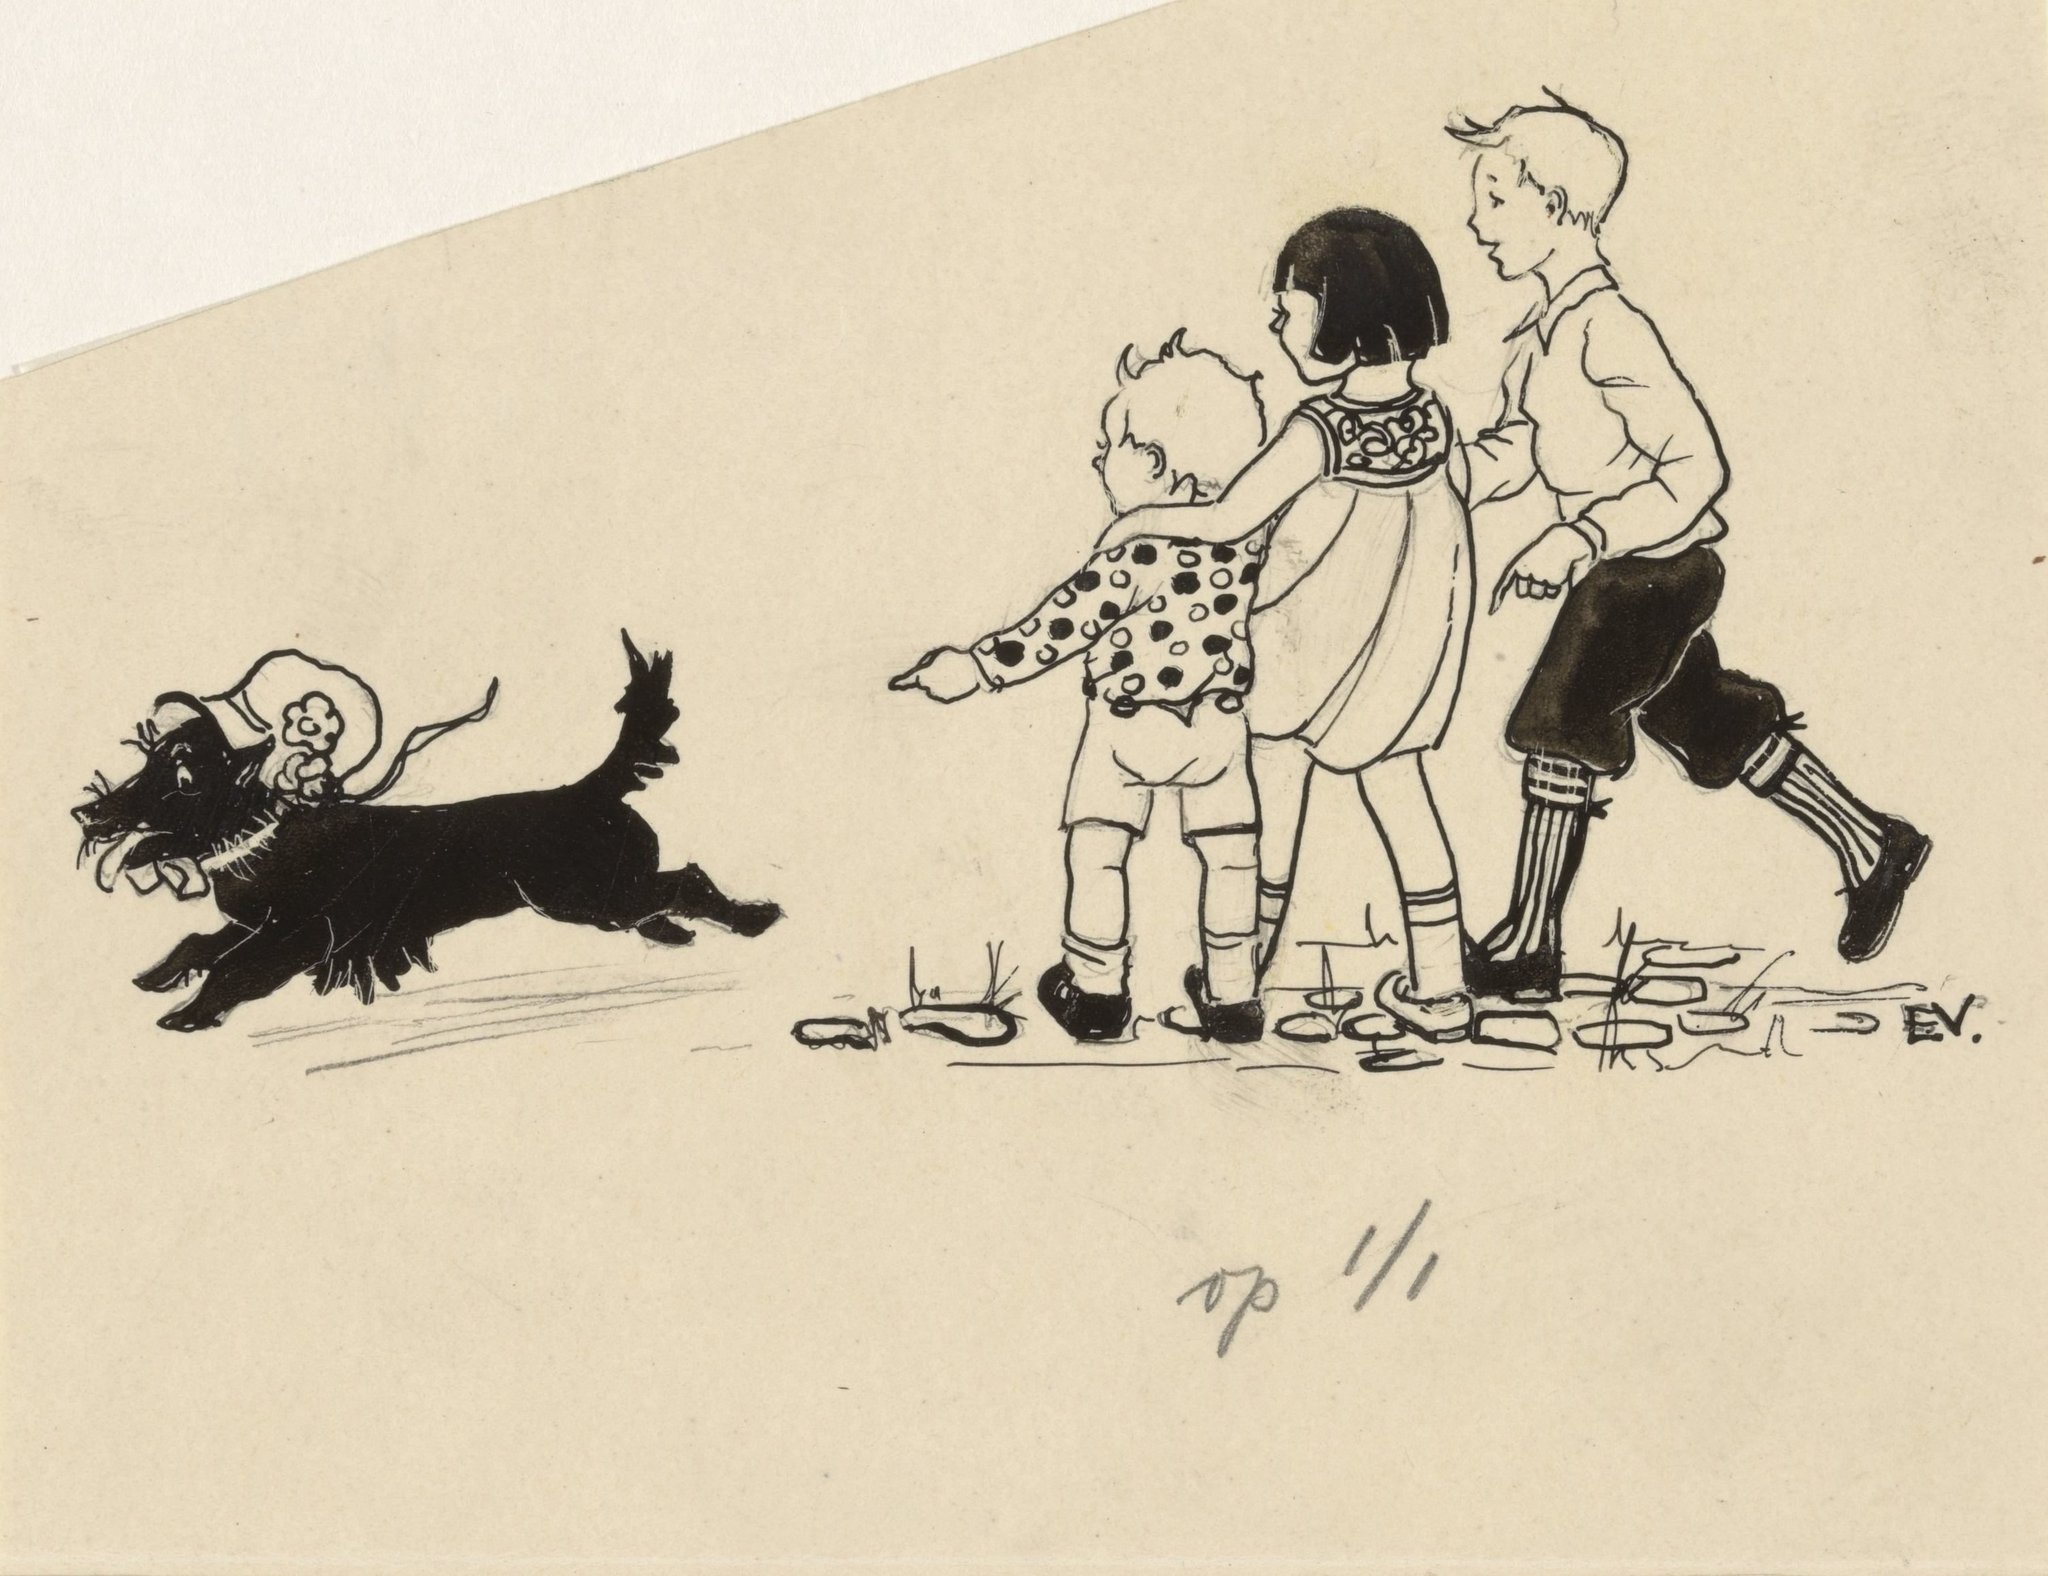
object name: drawing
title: Drie kinderen kijkend naar een rennende hond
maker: elly verstijnen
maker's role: draughtsman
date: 1932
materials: ink, paper, pencil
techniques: pen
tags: child, dog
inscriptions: collector's mark: Lugt 2228a, signature: ‘EV.’, :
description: Drie kinderen staan op een rij en kijken naar een hond die voorbij rent met een losse lijn. Eén van de kinderen wijst naar de hond, die een stuk stof in de bek heeft en bloemen rond de halsband draagt.